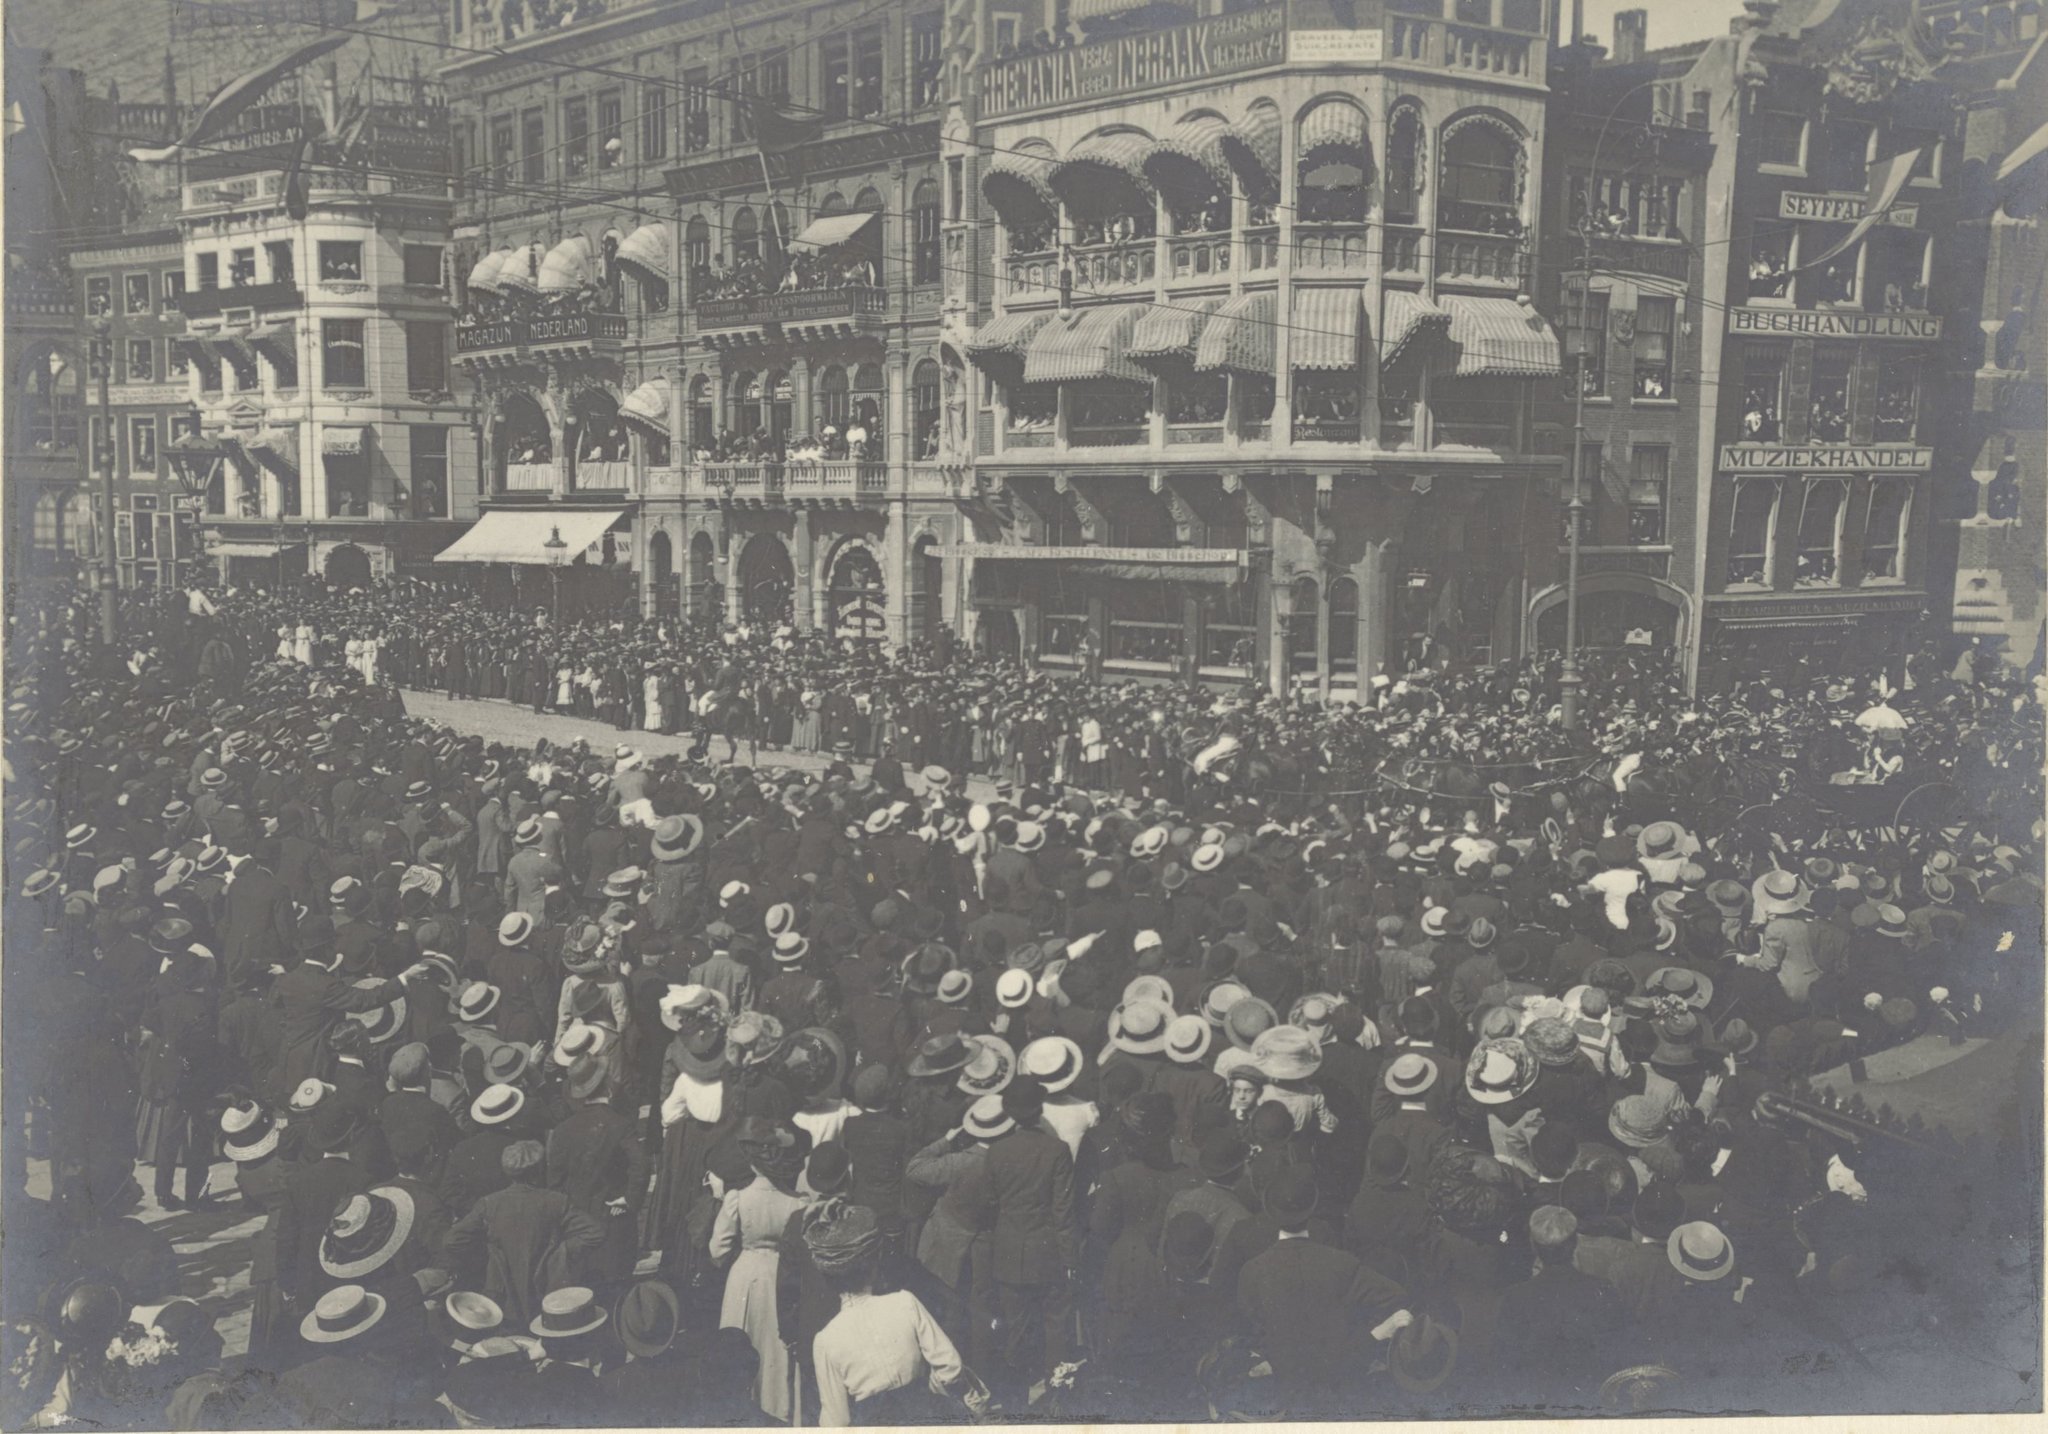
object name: photograph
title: Stadsrit door Koningin Wilhelmina 1900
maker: Anonymous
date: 1900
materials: paper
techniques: carbon print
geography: amsterdam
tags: the hague, print maker, wilhelmina of the netherlands